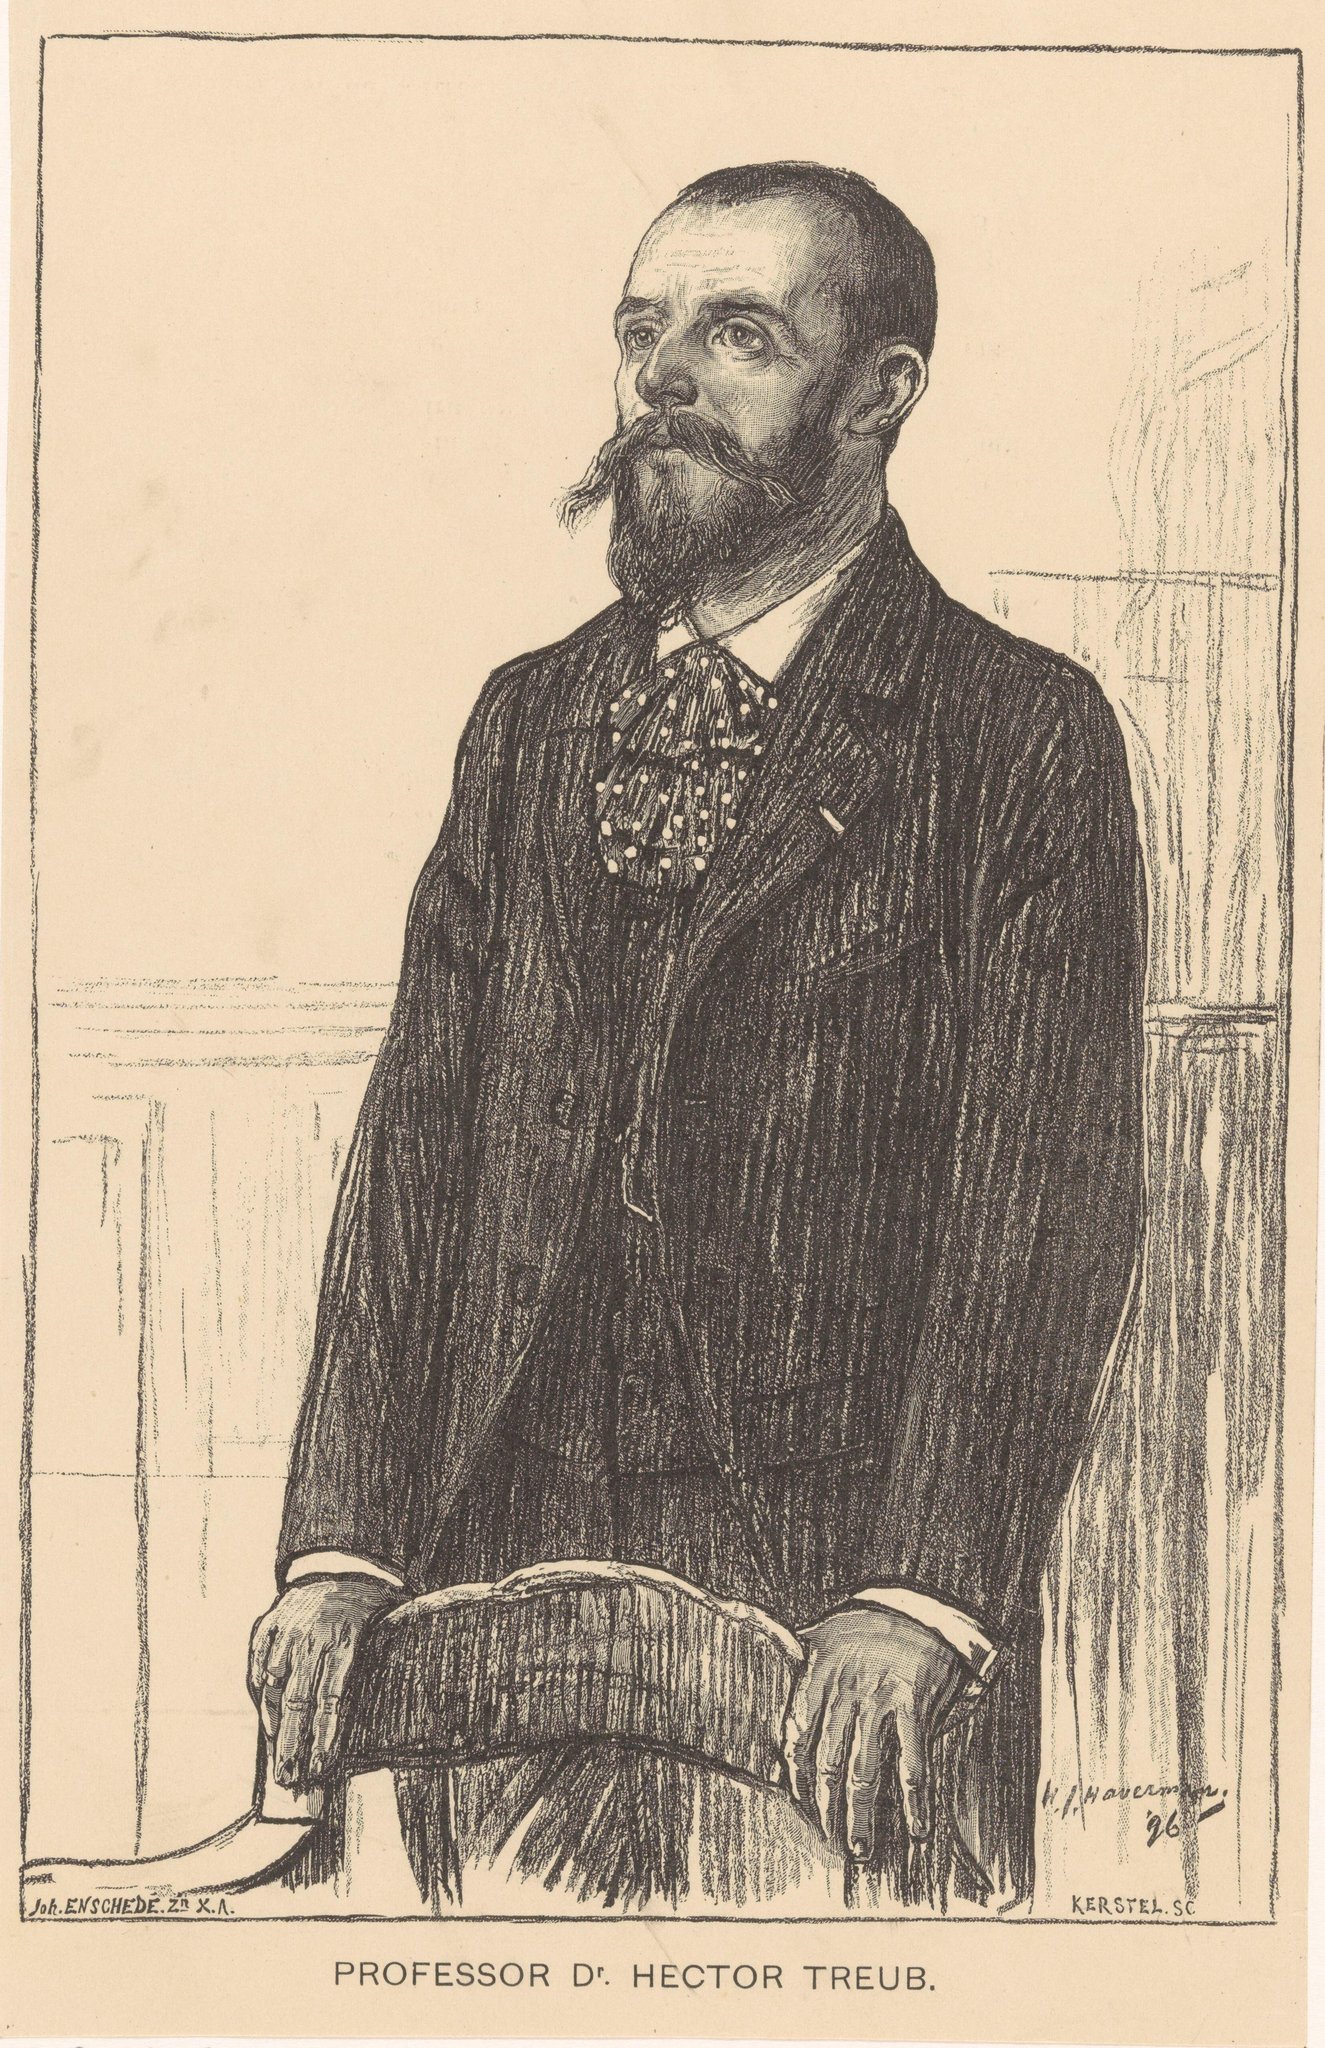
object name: print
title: Portret van Hector Treub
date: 1896-1906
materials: paper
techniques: lithograph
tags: voorschoten, physician, doctor, beard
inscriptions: collector's mark: Lugt 2228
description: Een portret van de arts Hector Treub met baard en snor, staand bij een stoel waarvan hij de rugleuning met beide handen vasthoudt.